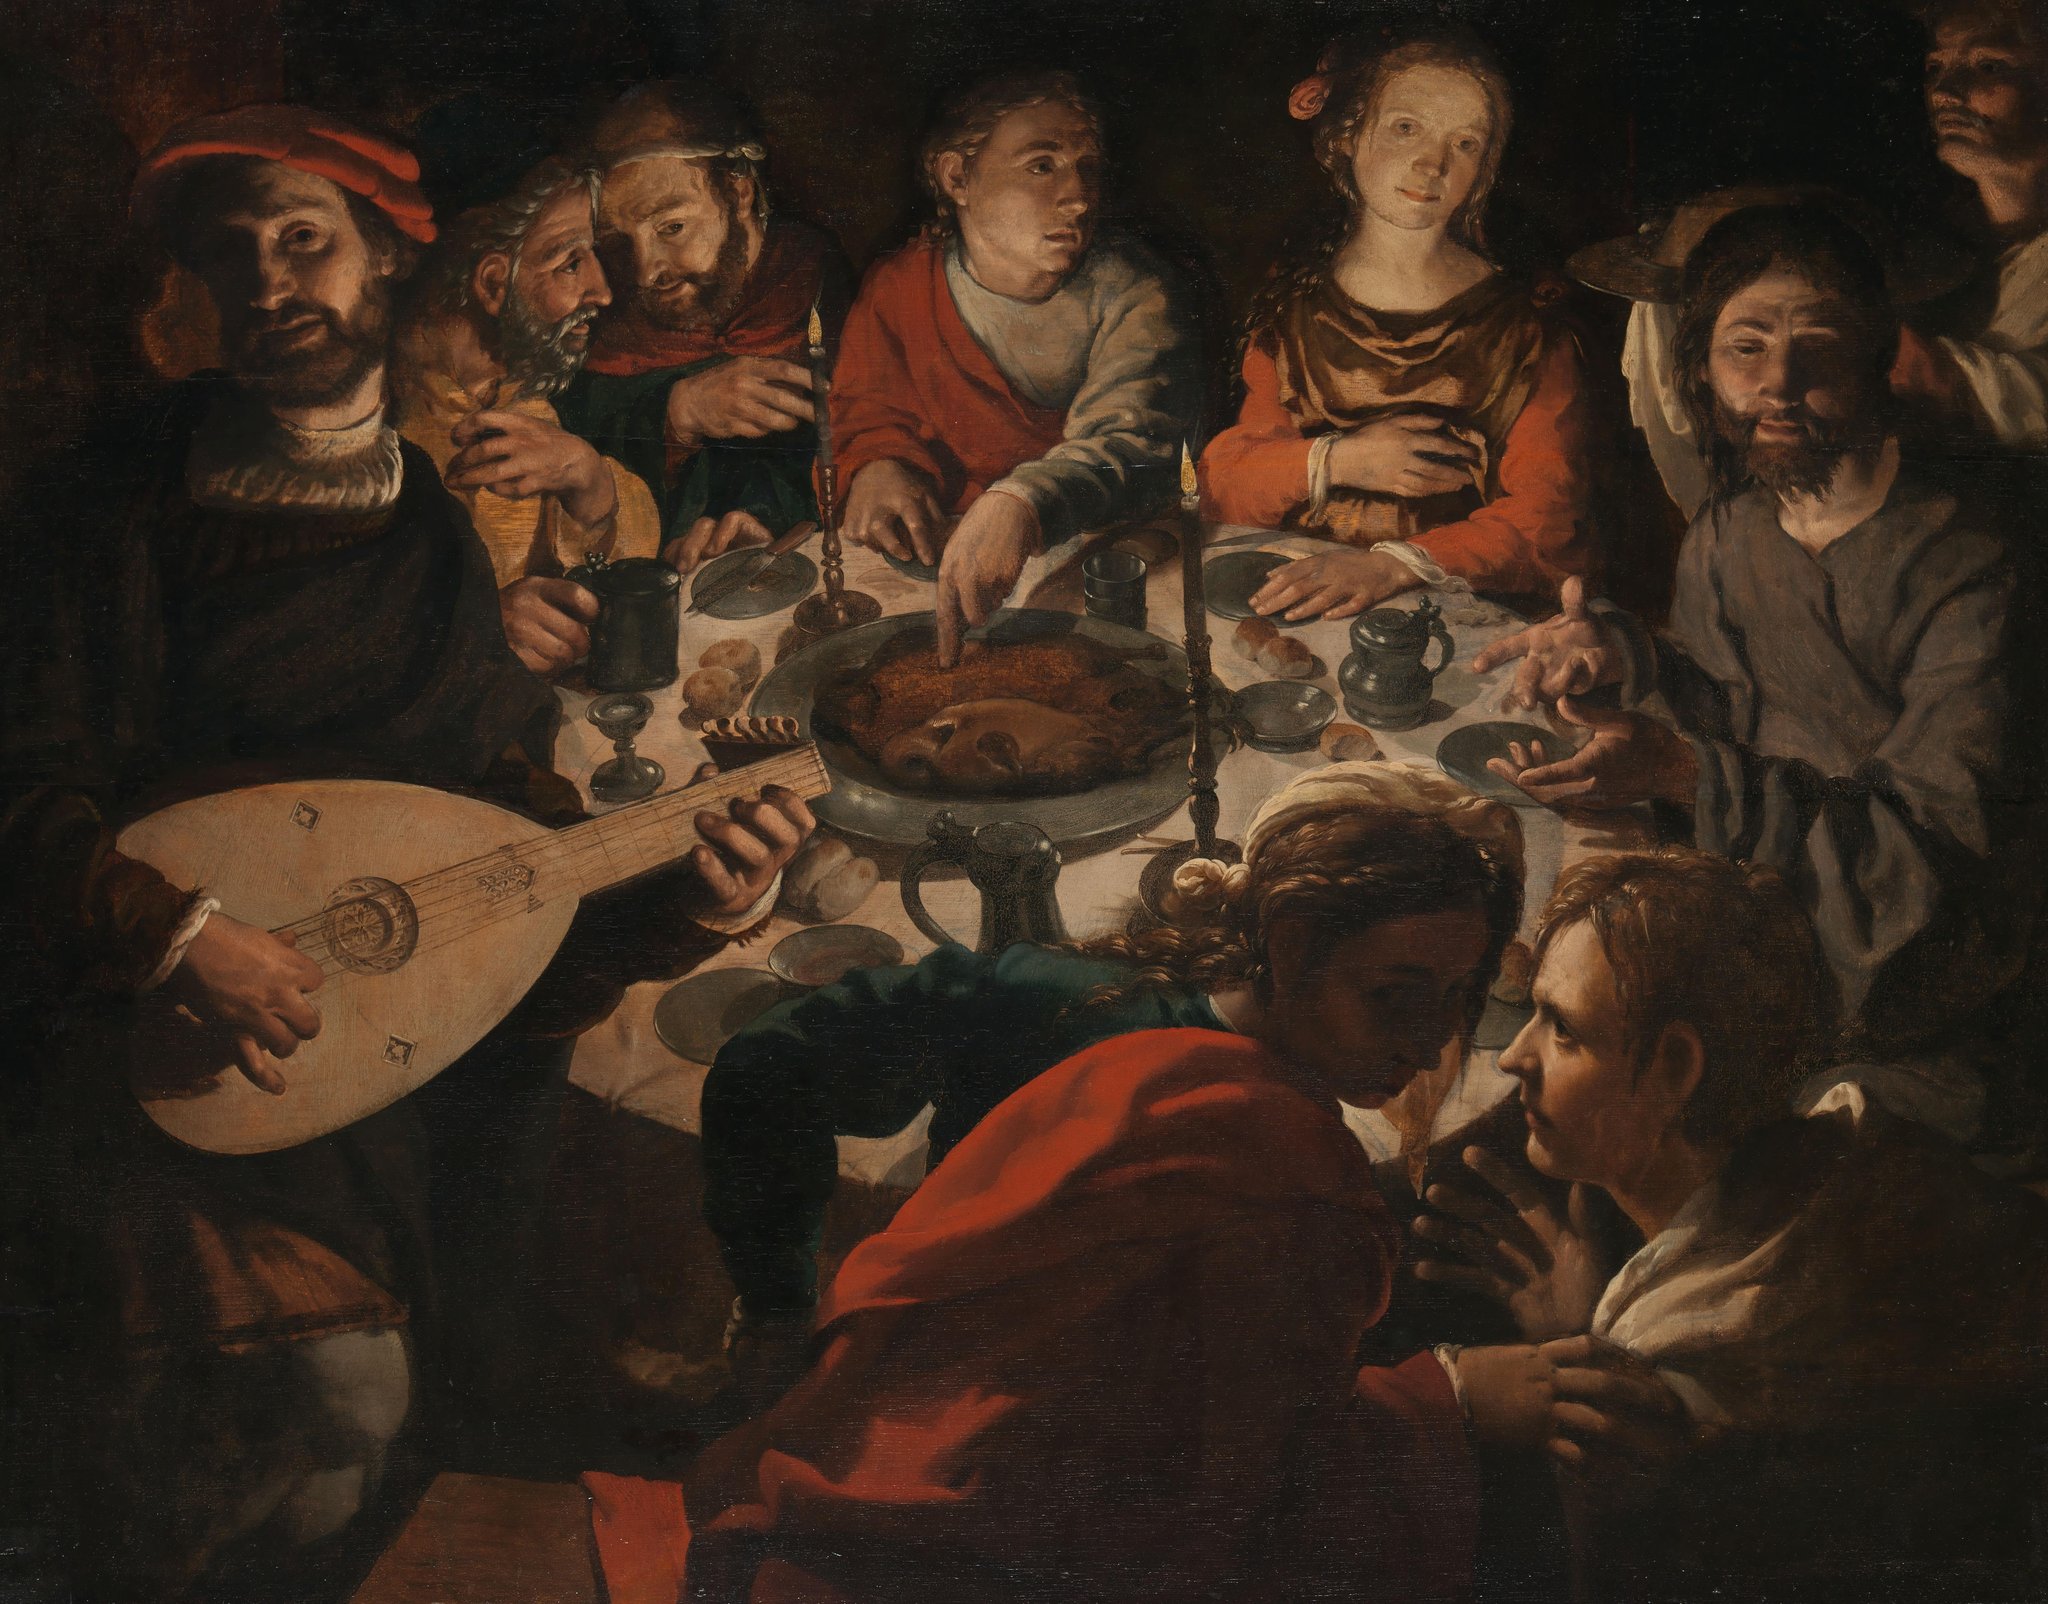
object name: painting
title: The calling of St John during the marriage at Cana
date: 1530-1532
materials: oil, panel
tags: the apostle john the evangelist; possible attributes: book, cauldron, chalice with snake, eagle, palm, scroll - vocation, conversion of male saint, the marriage-feast at cana (john 2:1-11)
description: In this night scene – a novelty in painting at the time – Vermeyen succeeded in creating a dramatic effect. Candlelight plays over the faces and casts dark shadows. For the flames, Vermeyen used gold leaf. He was well ahead of his time: only around 1600 did the nocturn as a genre become more widely known through the Italian artist Caravaggio.